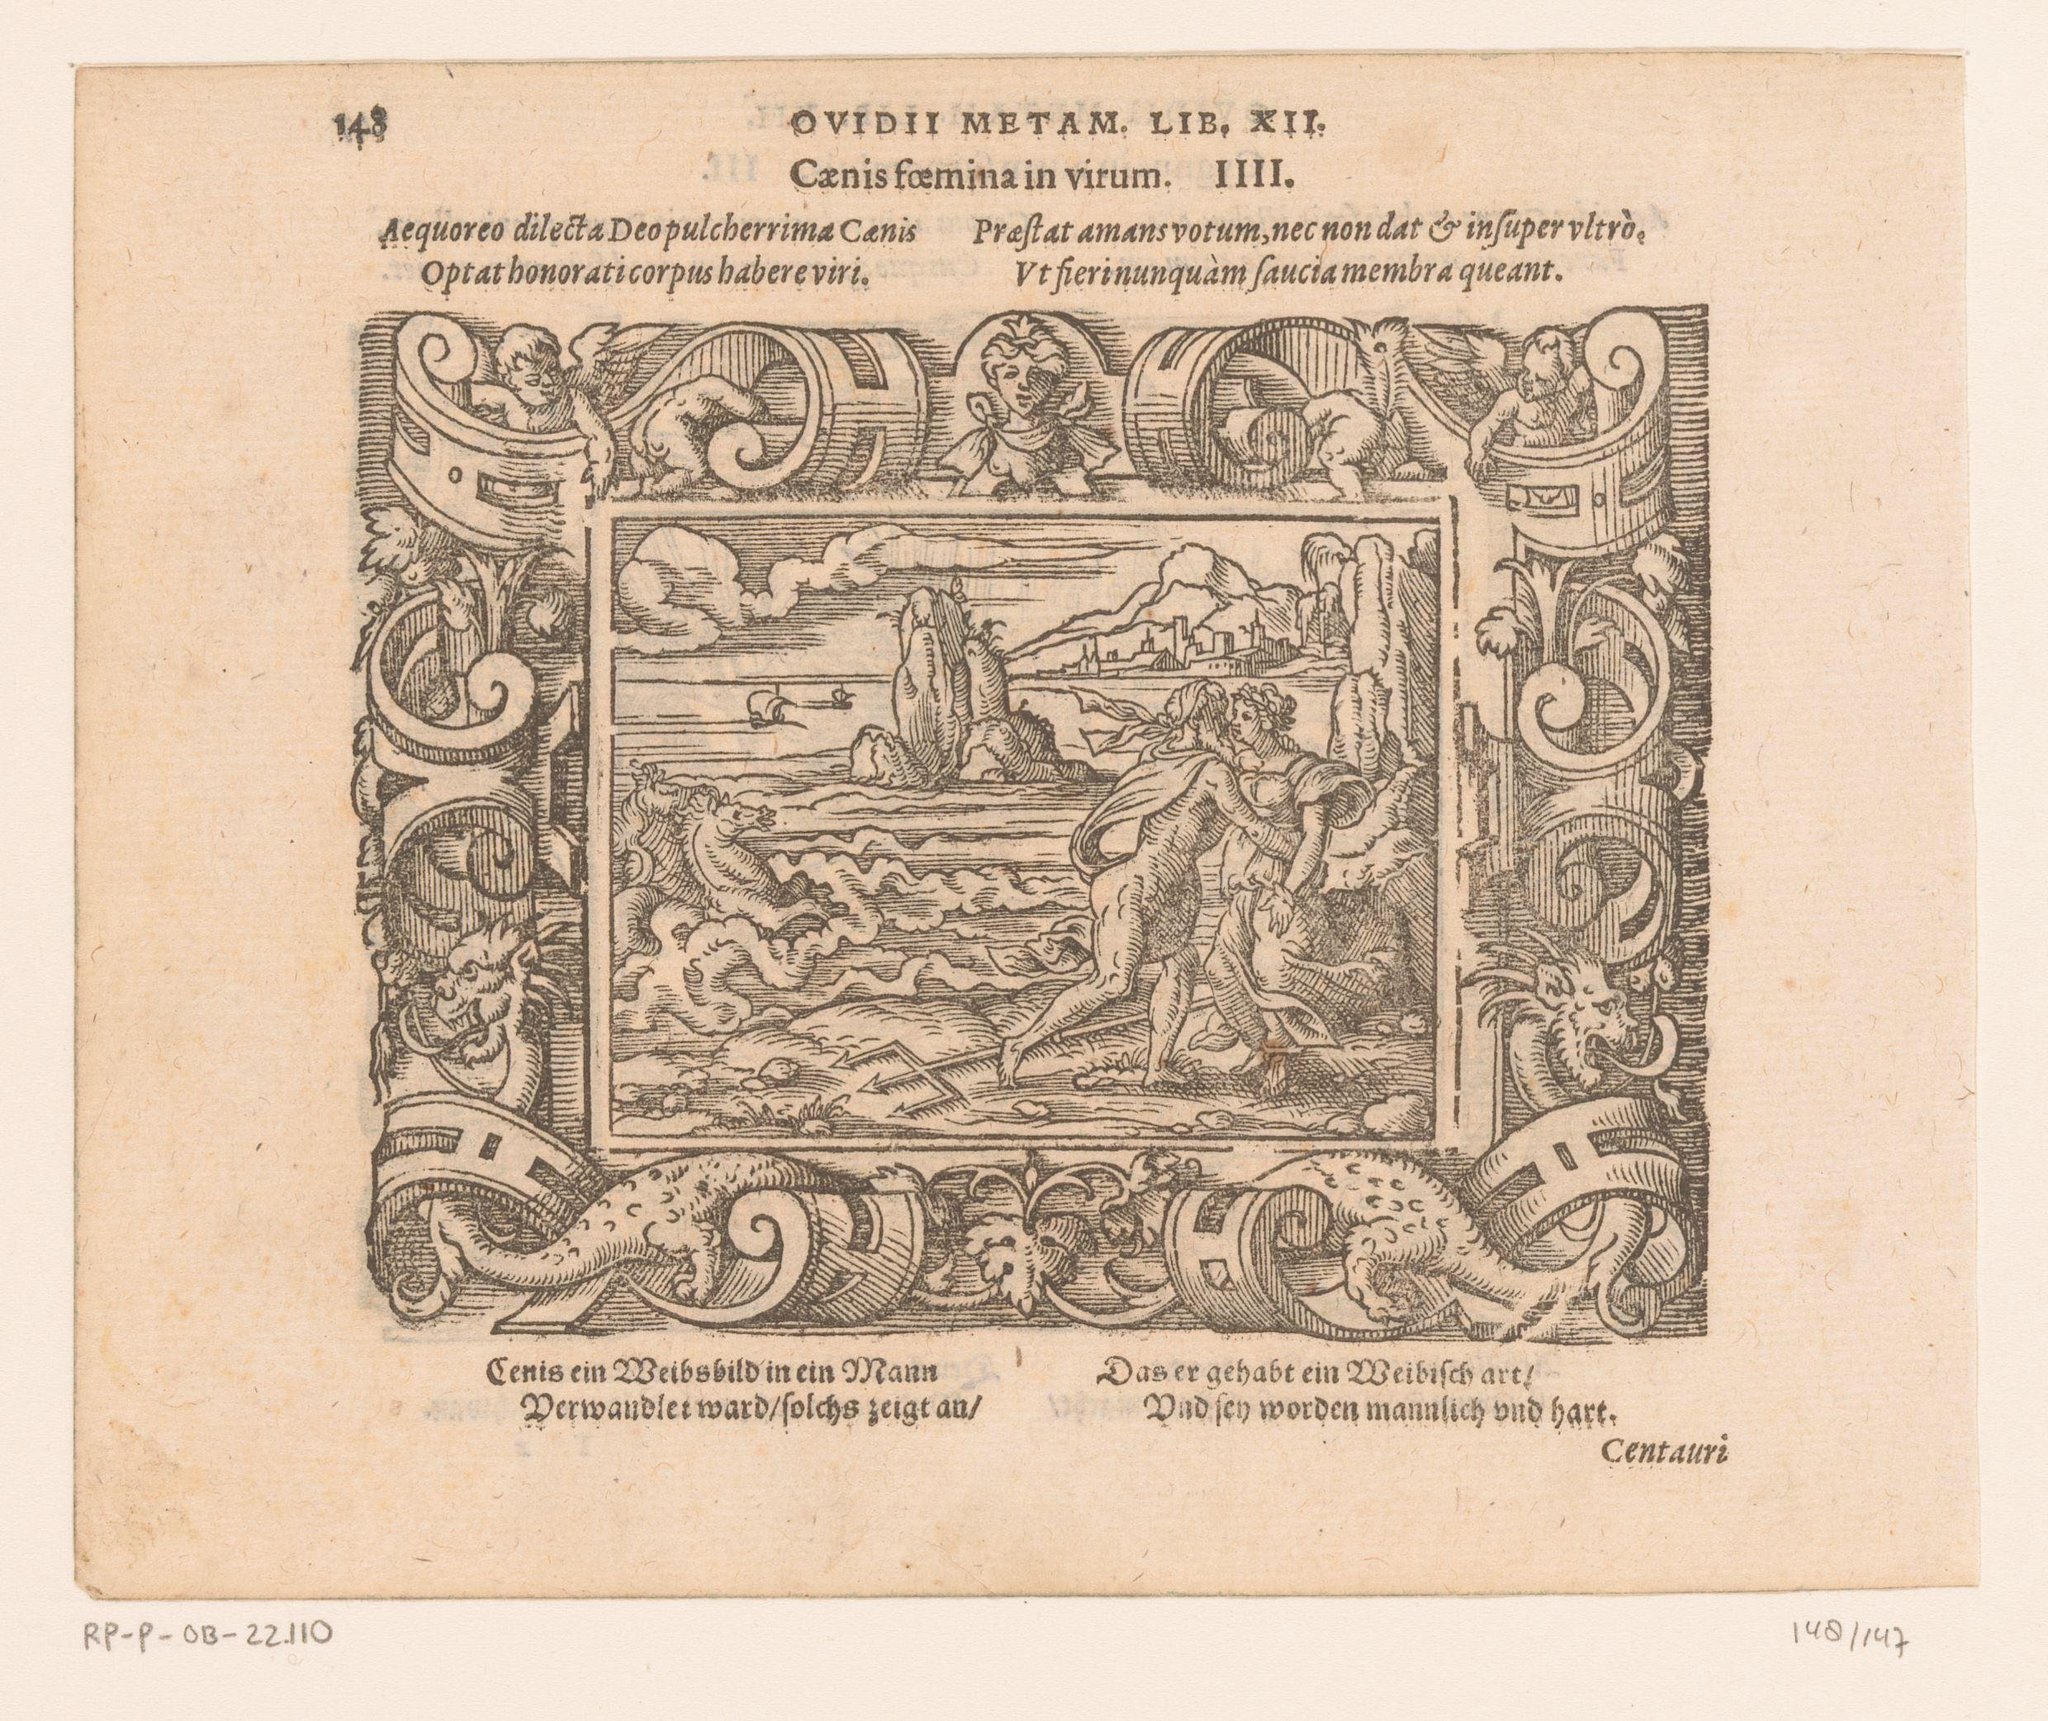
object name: book illustration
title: Caenis omhelsd door Neptunus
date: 1569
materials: paper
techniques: letterpress printing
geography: nuremberg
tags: caenis changed to caeneus: when neptune has ravished caenis, he changes her at her request into the invulnerable hero caeneus (ovid, metamorphoses xii 201), scrollwork, strapwork ~ ornament, transgender, transsexual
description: Illustratie bij de Metamorfosen van Ovidius, afkomstig uit de publicatie: Posthius, Johannes. Tetrasticha in Ovidii metam. Frankfurt am Main: Georg Rab en Sigmund Feyerabend en erven Weigand Han, 1569. De voorstellingen en ornamentranden van deze boekillustraties zijn van twee aparte blokken gedrukt. Beide werden afzonderlijk van elkaar ook gebruikt voor andere publicaties, en de ornamentranden werden eveneens binnen deze publicatie meerdere keren gebruikt.